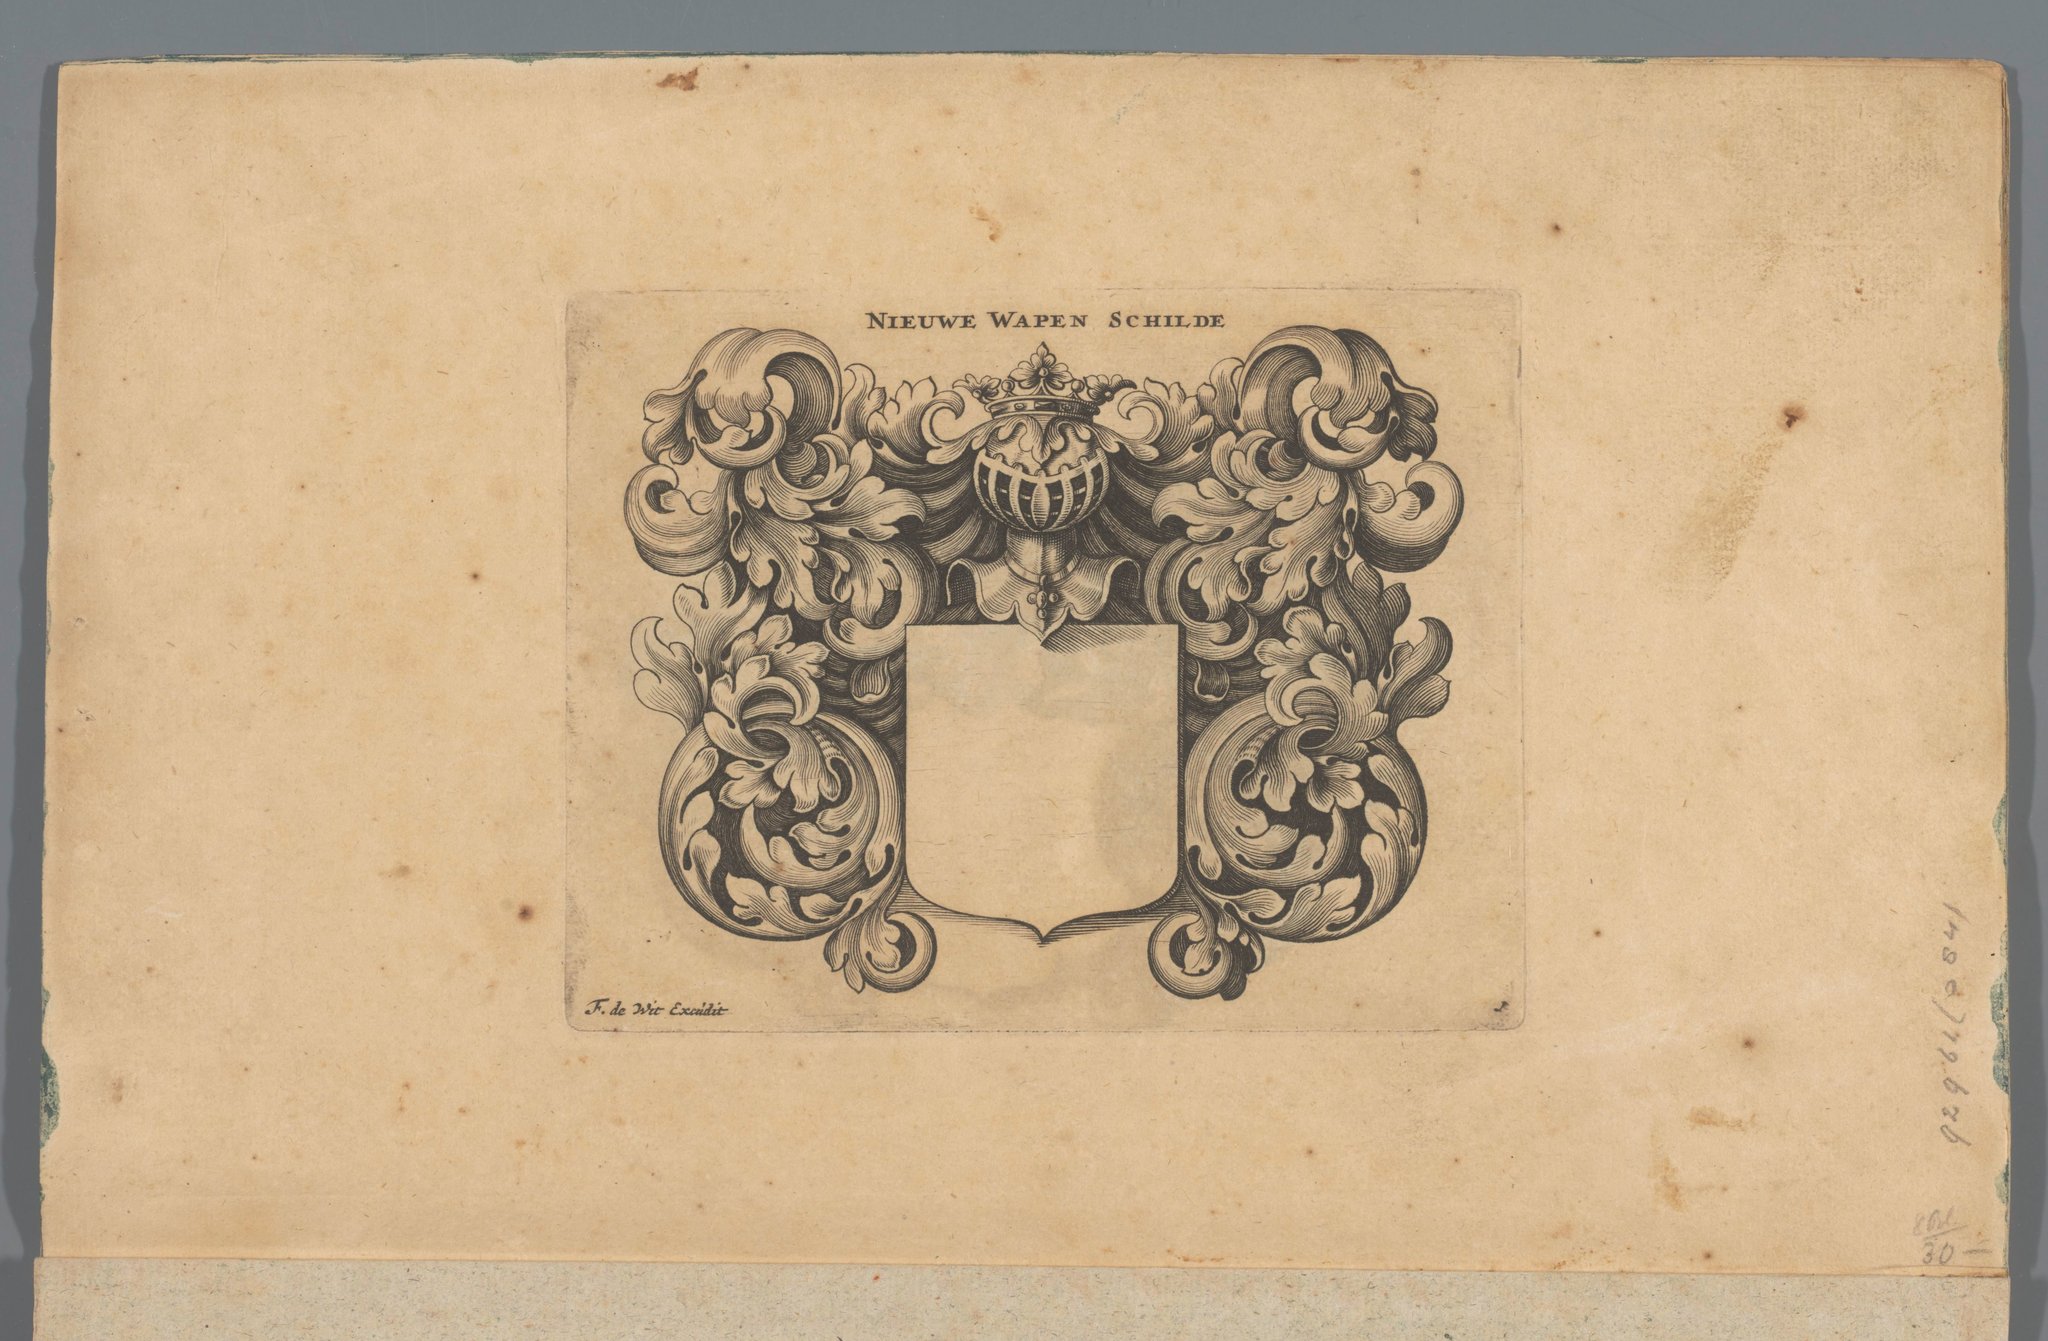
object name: print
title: Cartouche voor wapenschild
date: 1630-1680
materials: paper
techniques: engraving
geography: amsterdam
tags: armorial bearing, heraldry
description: Prent nr. 1 in een bundel van acht genummerde prenten met cartouches voor wapenschilden, eerste blad getiteld "Nieuwe Wapen Schilde". Met een touwtje samengebonden in een kaft van 19e-eeuws sierpapier.